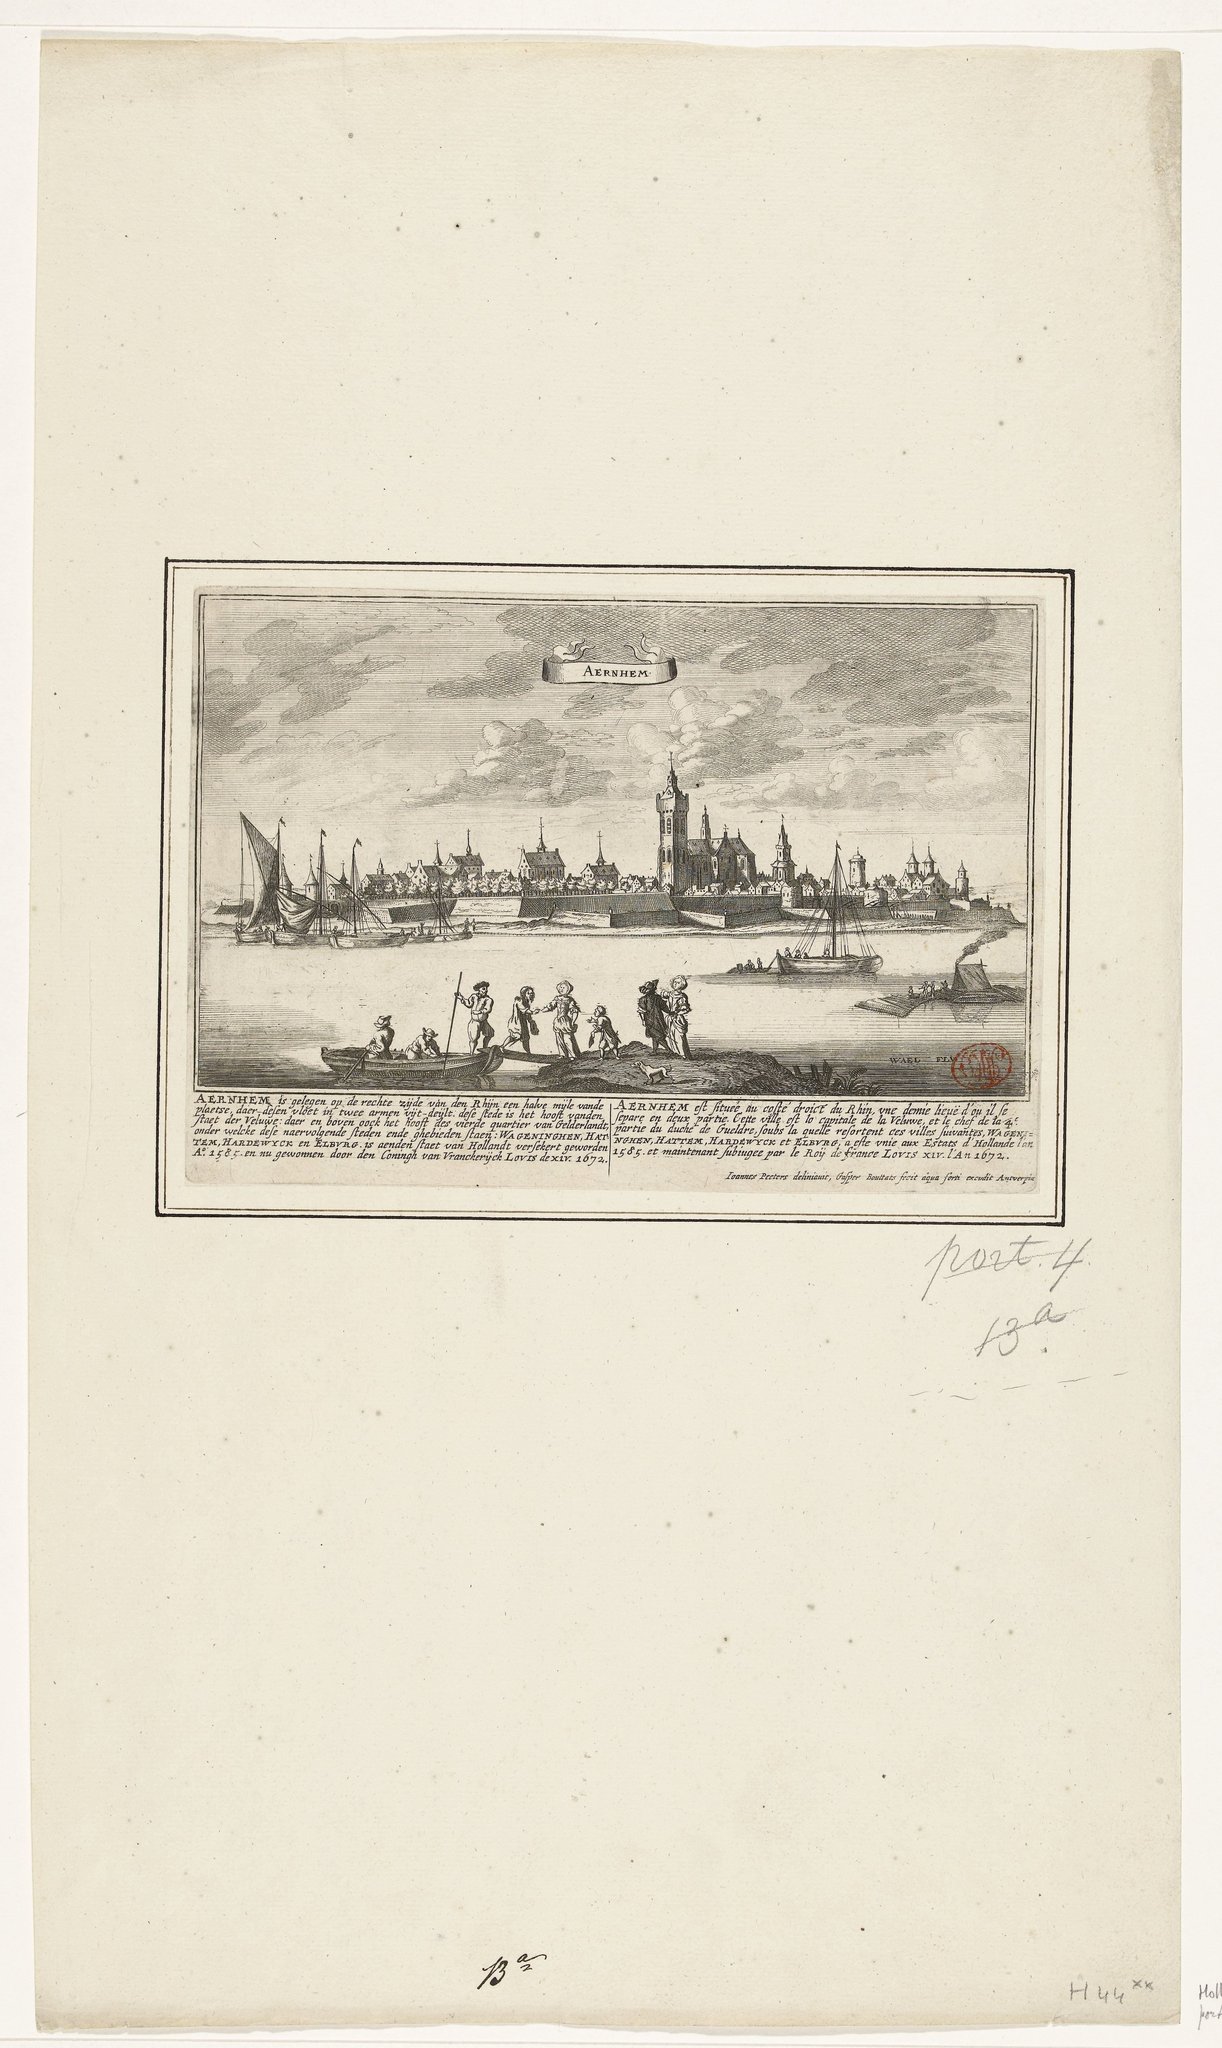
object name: print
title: Thooneel der Steden ende Sterckten van 't Vereenight Nederlandt met d'aengrensende Plaetsen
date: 1679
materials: paper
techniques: etching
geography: antwerp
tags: prospect of city, town panorama, silhouette of city, arnhem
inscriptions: number, collector's mark: Lugt 2233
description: Gezicht op de stad Arnhem Op de voorgrond, buiten de stadsmuren, de Nederrijn. Enkele schepen varen over de rivier. Op de voorgrond laat een veerpont passagiers uit. Boven het stadsgezicht een cartouche met de naam van de stad. De prent heeft een Nederlands en Frans onderschrift.